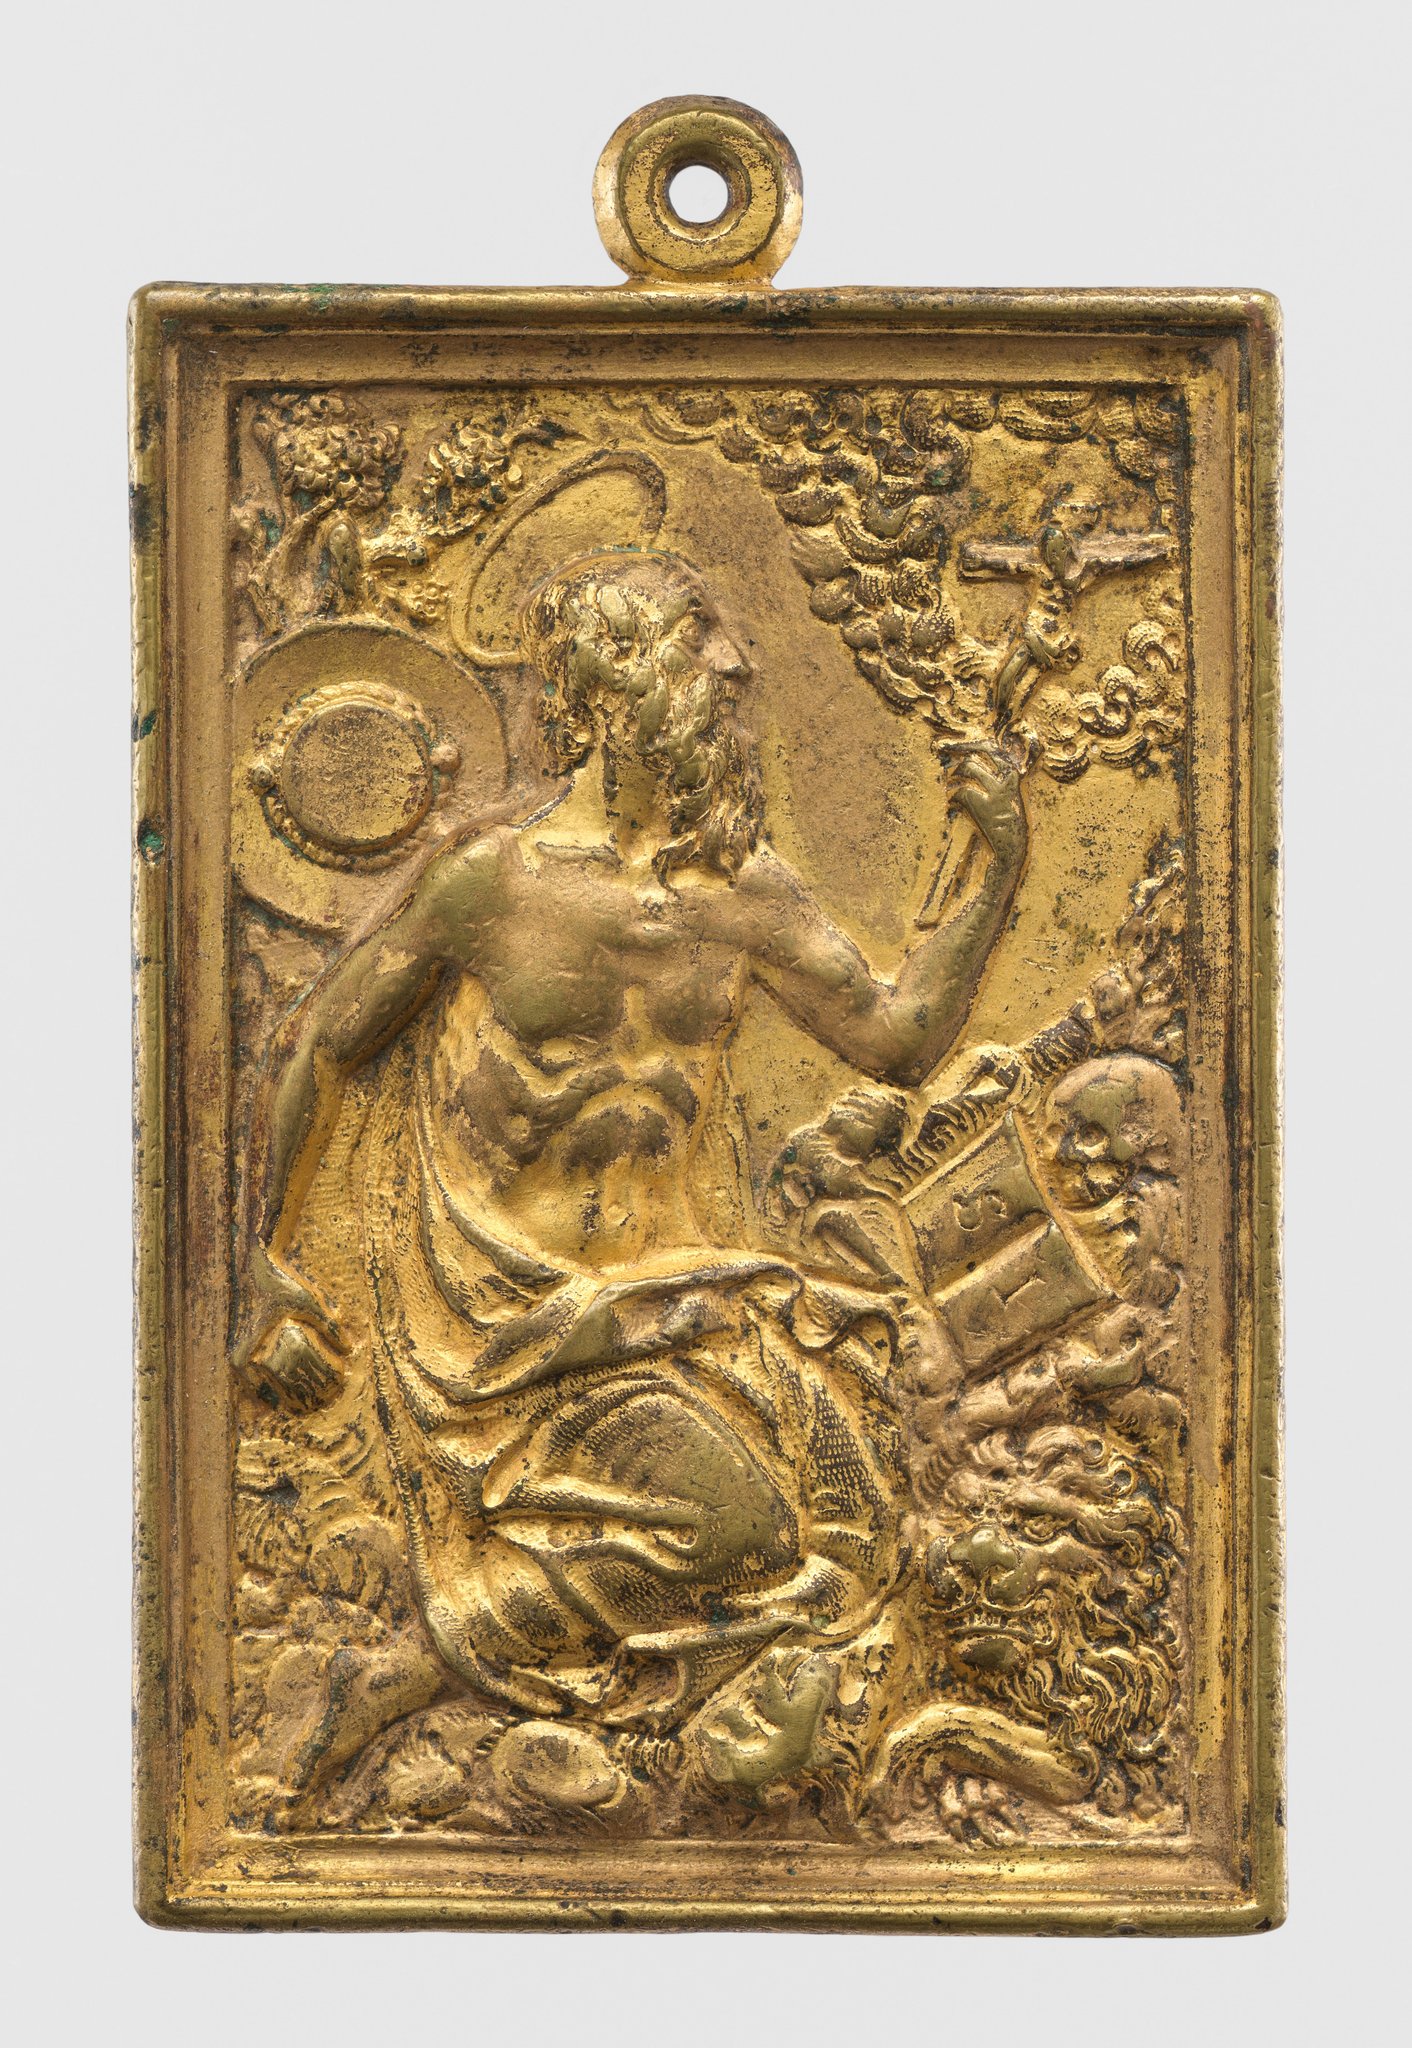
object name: plaquette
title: Saint Jerome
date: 1601-1633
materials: gilt bronze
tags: lions,saint jerome